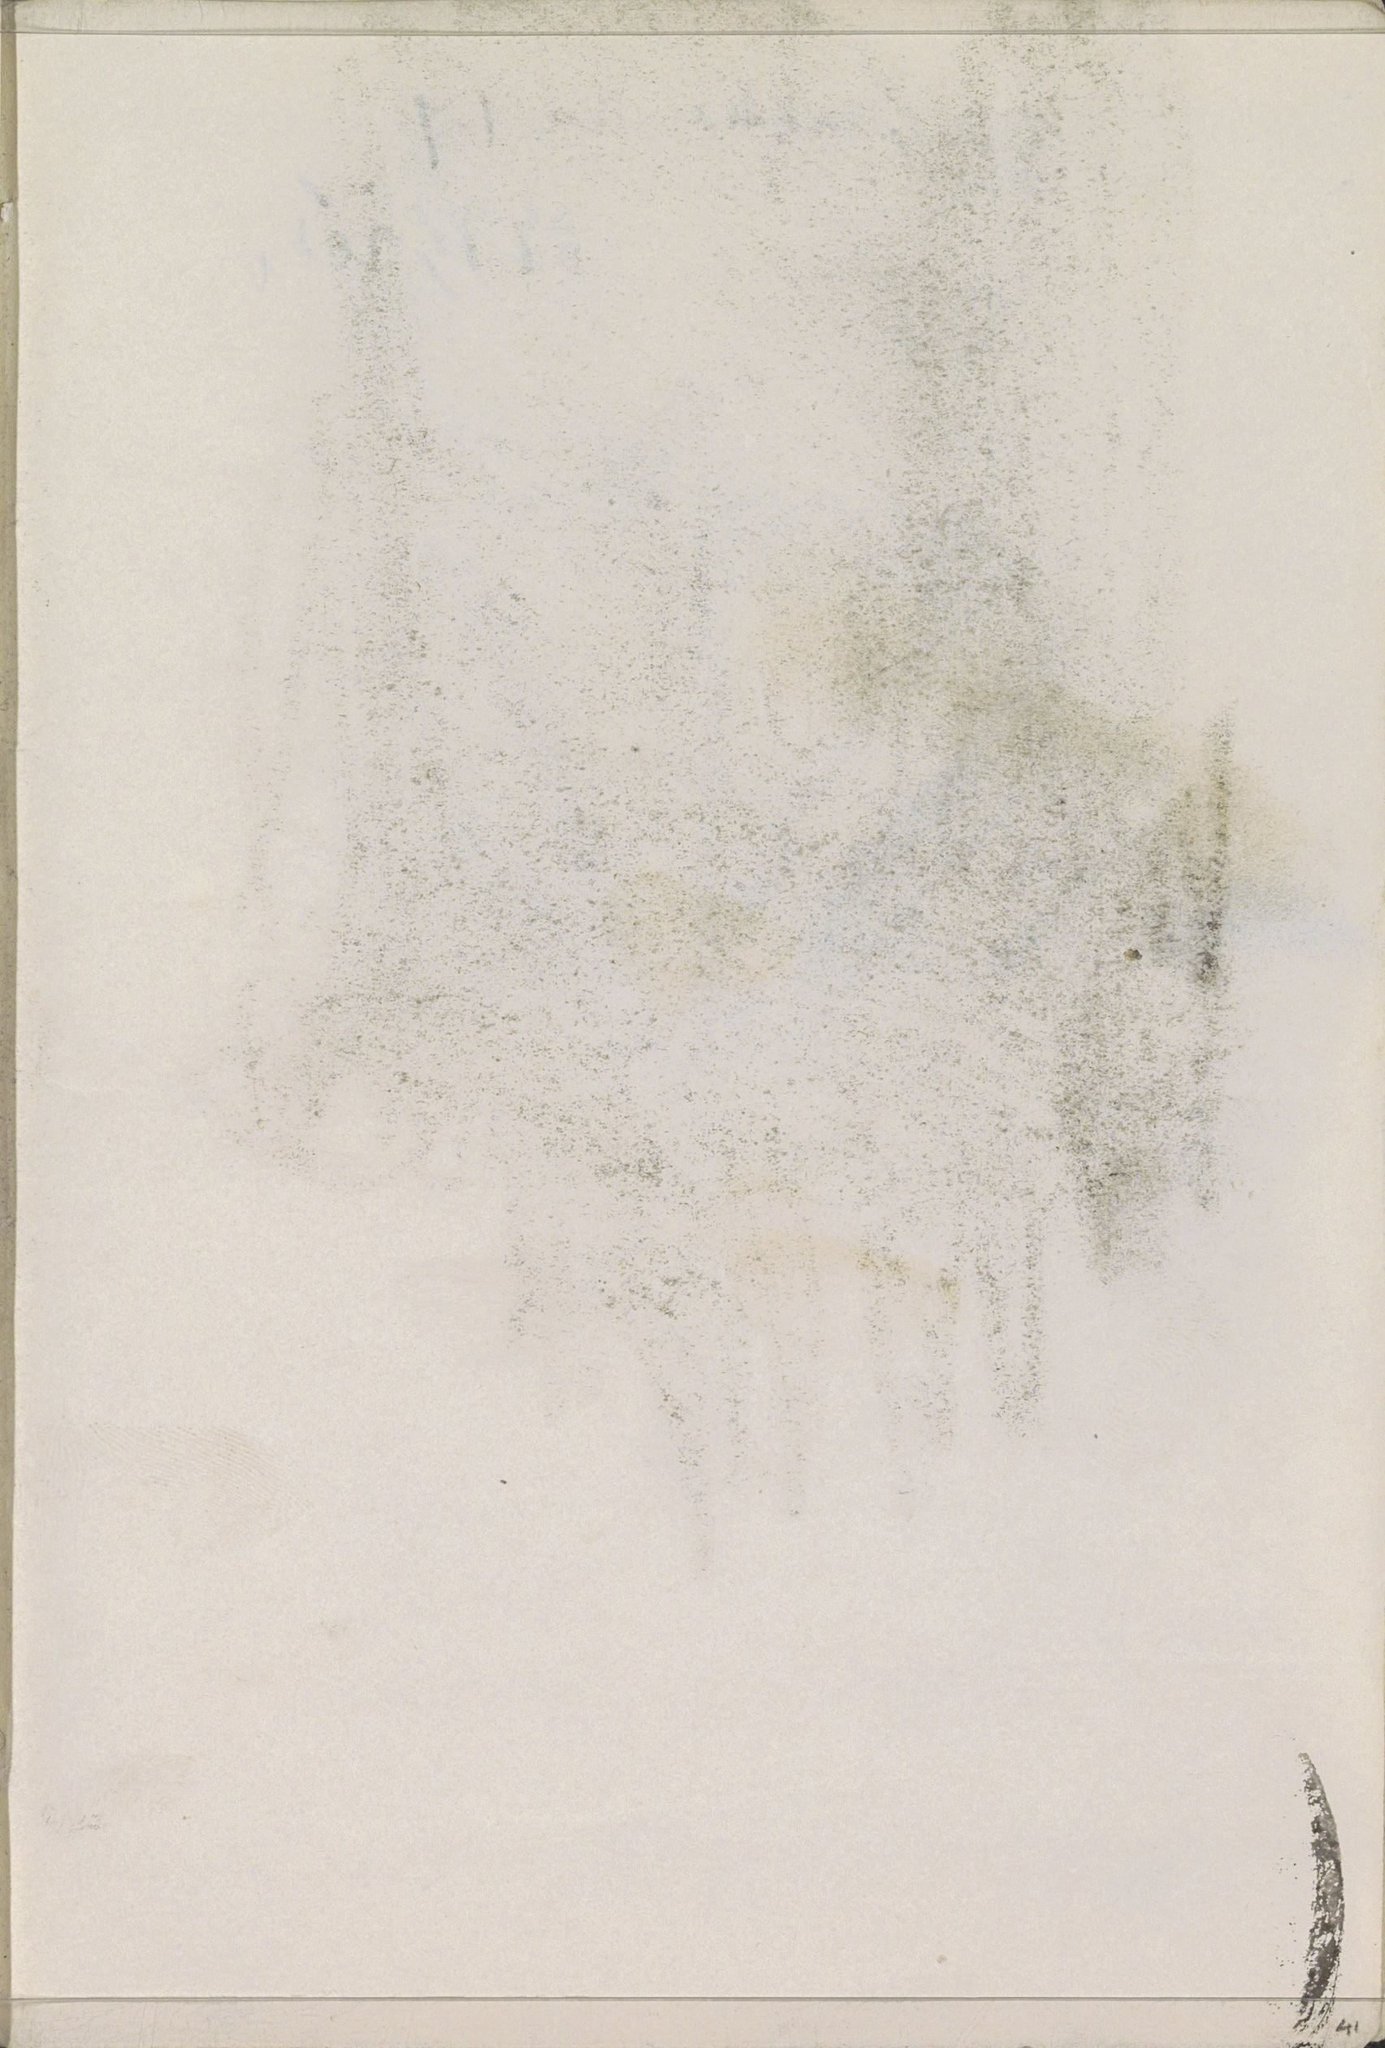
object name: sketchbook leaf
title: Abklatsch van de krijttekening op blad 40 verso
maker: isaac israels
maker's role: draughtsman, painter, print maker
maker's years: 1865-1934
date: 1875-1934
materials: paper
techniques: printmaking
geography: paris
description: Blad 42 recto uit schetsboek L met 42 bladen.